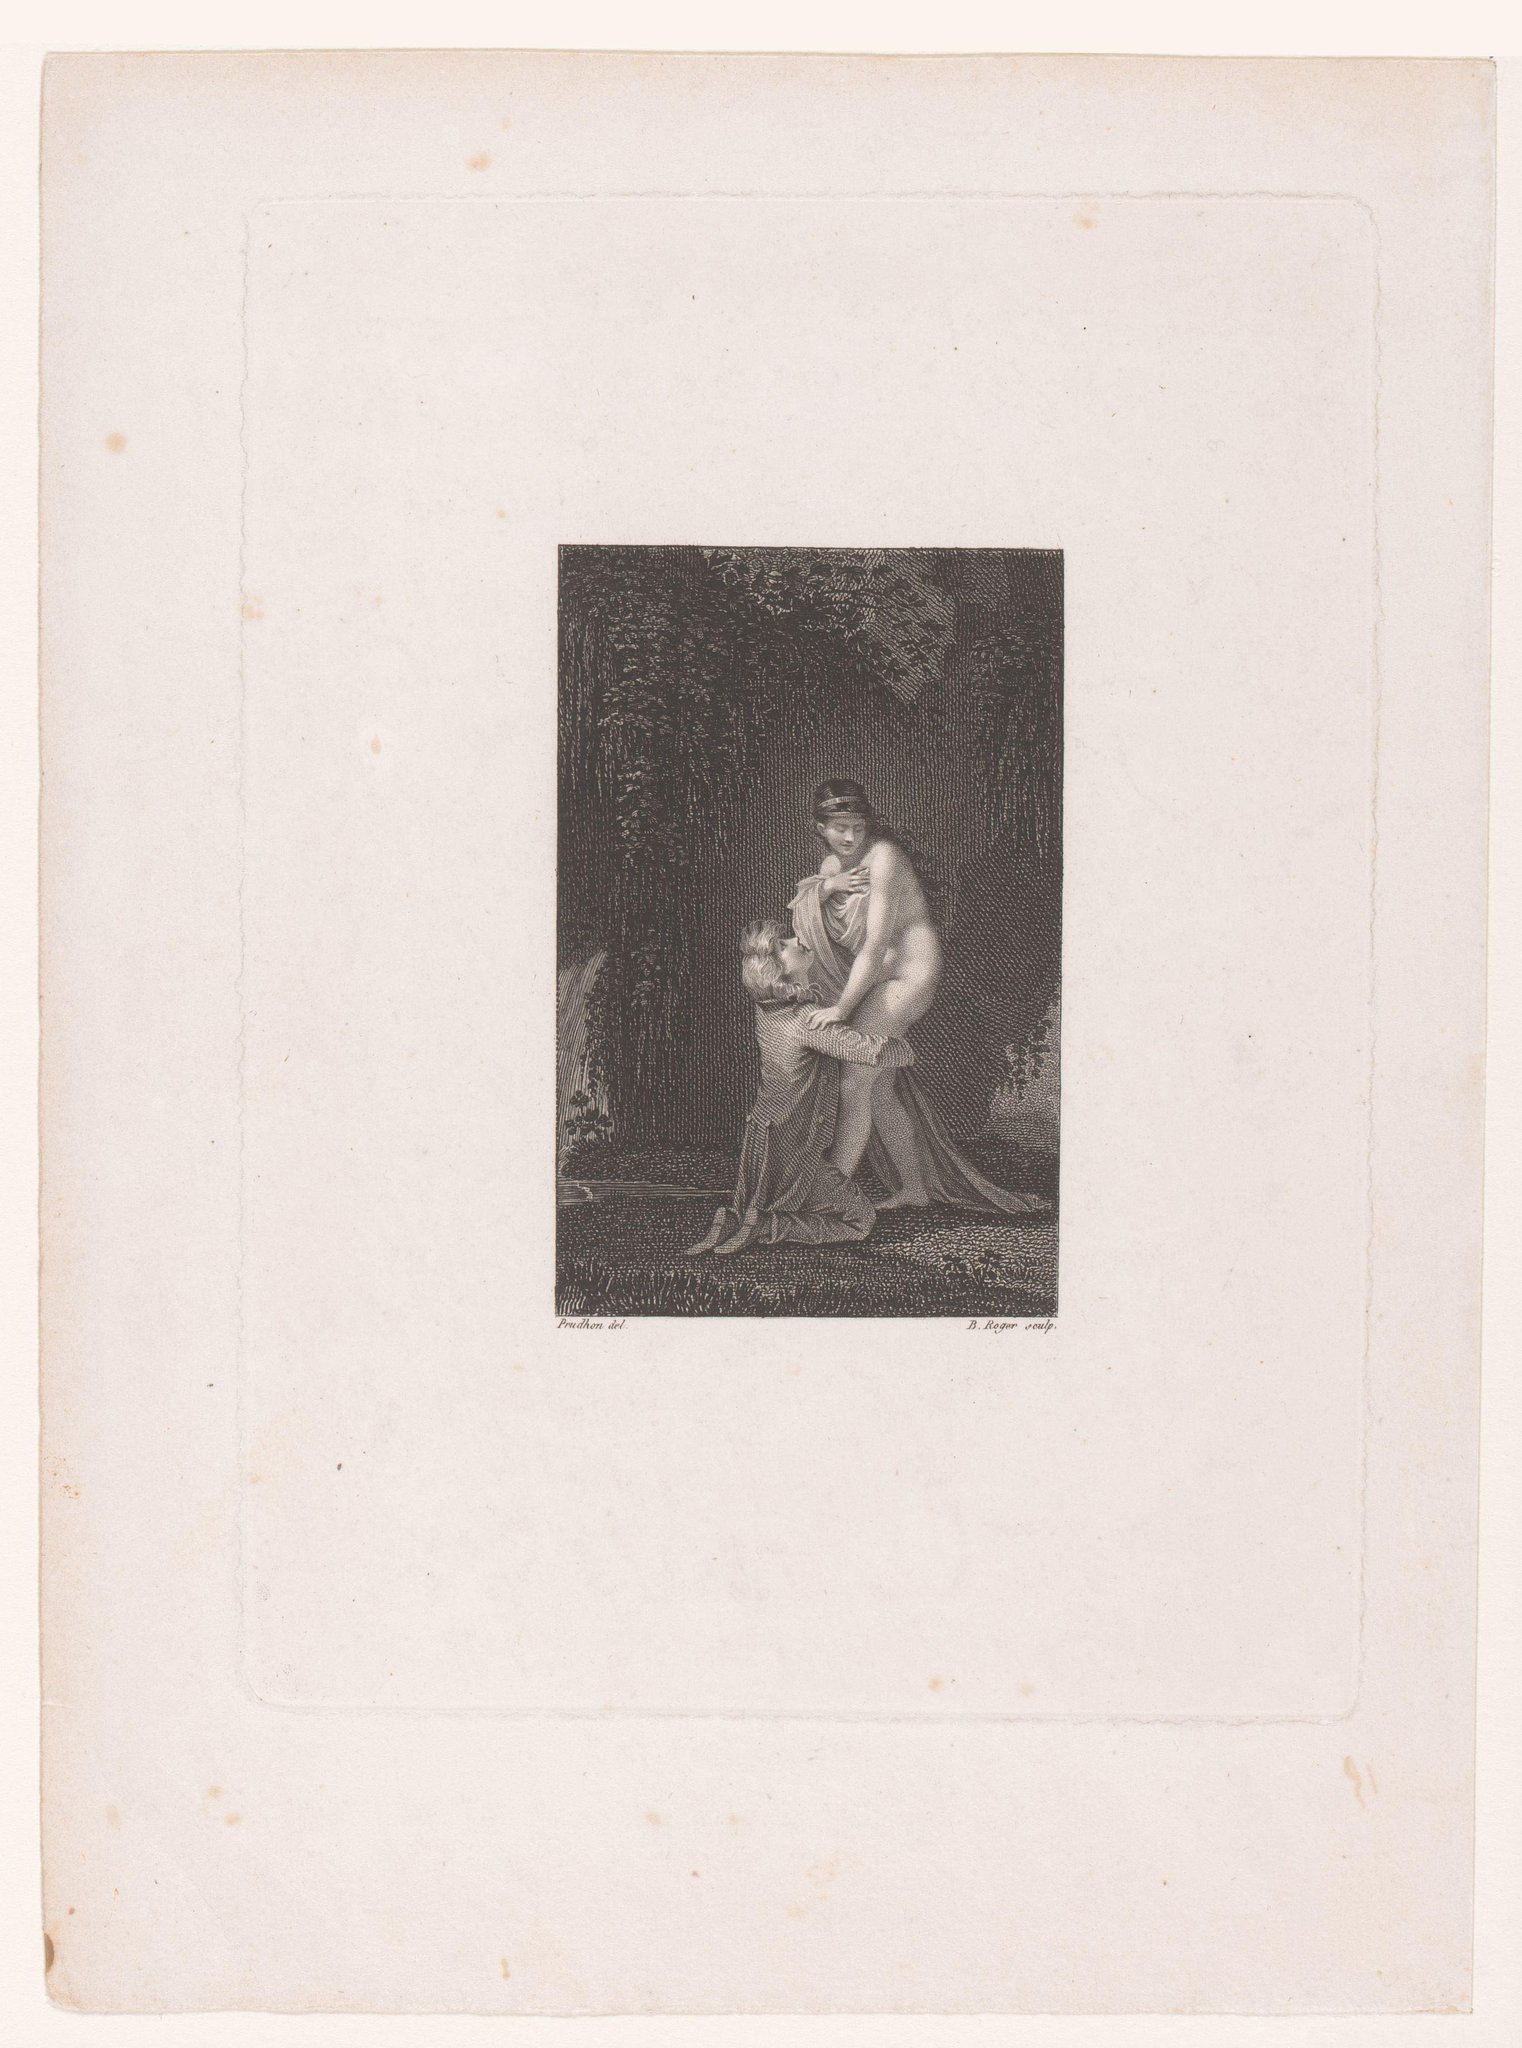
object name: print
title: Stellina en Edouard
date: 1799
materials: paper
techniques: engraving, etching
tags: literary characters and objects, couple of lovers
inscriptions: collector's mark: Lugt 2228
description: Scène uit "La Tribu Indienne" van Lucien Bonaparte.